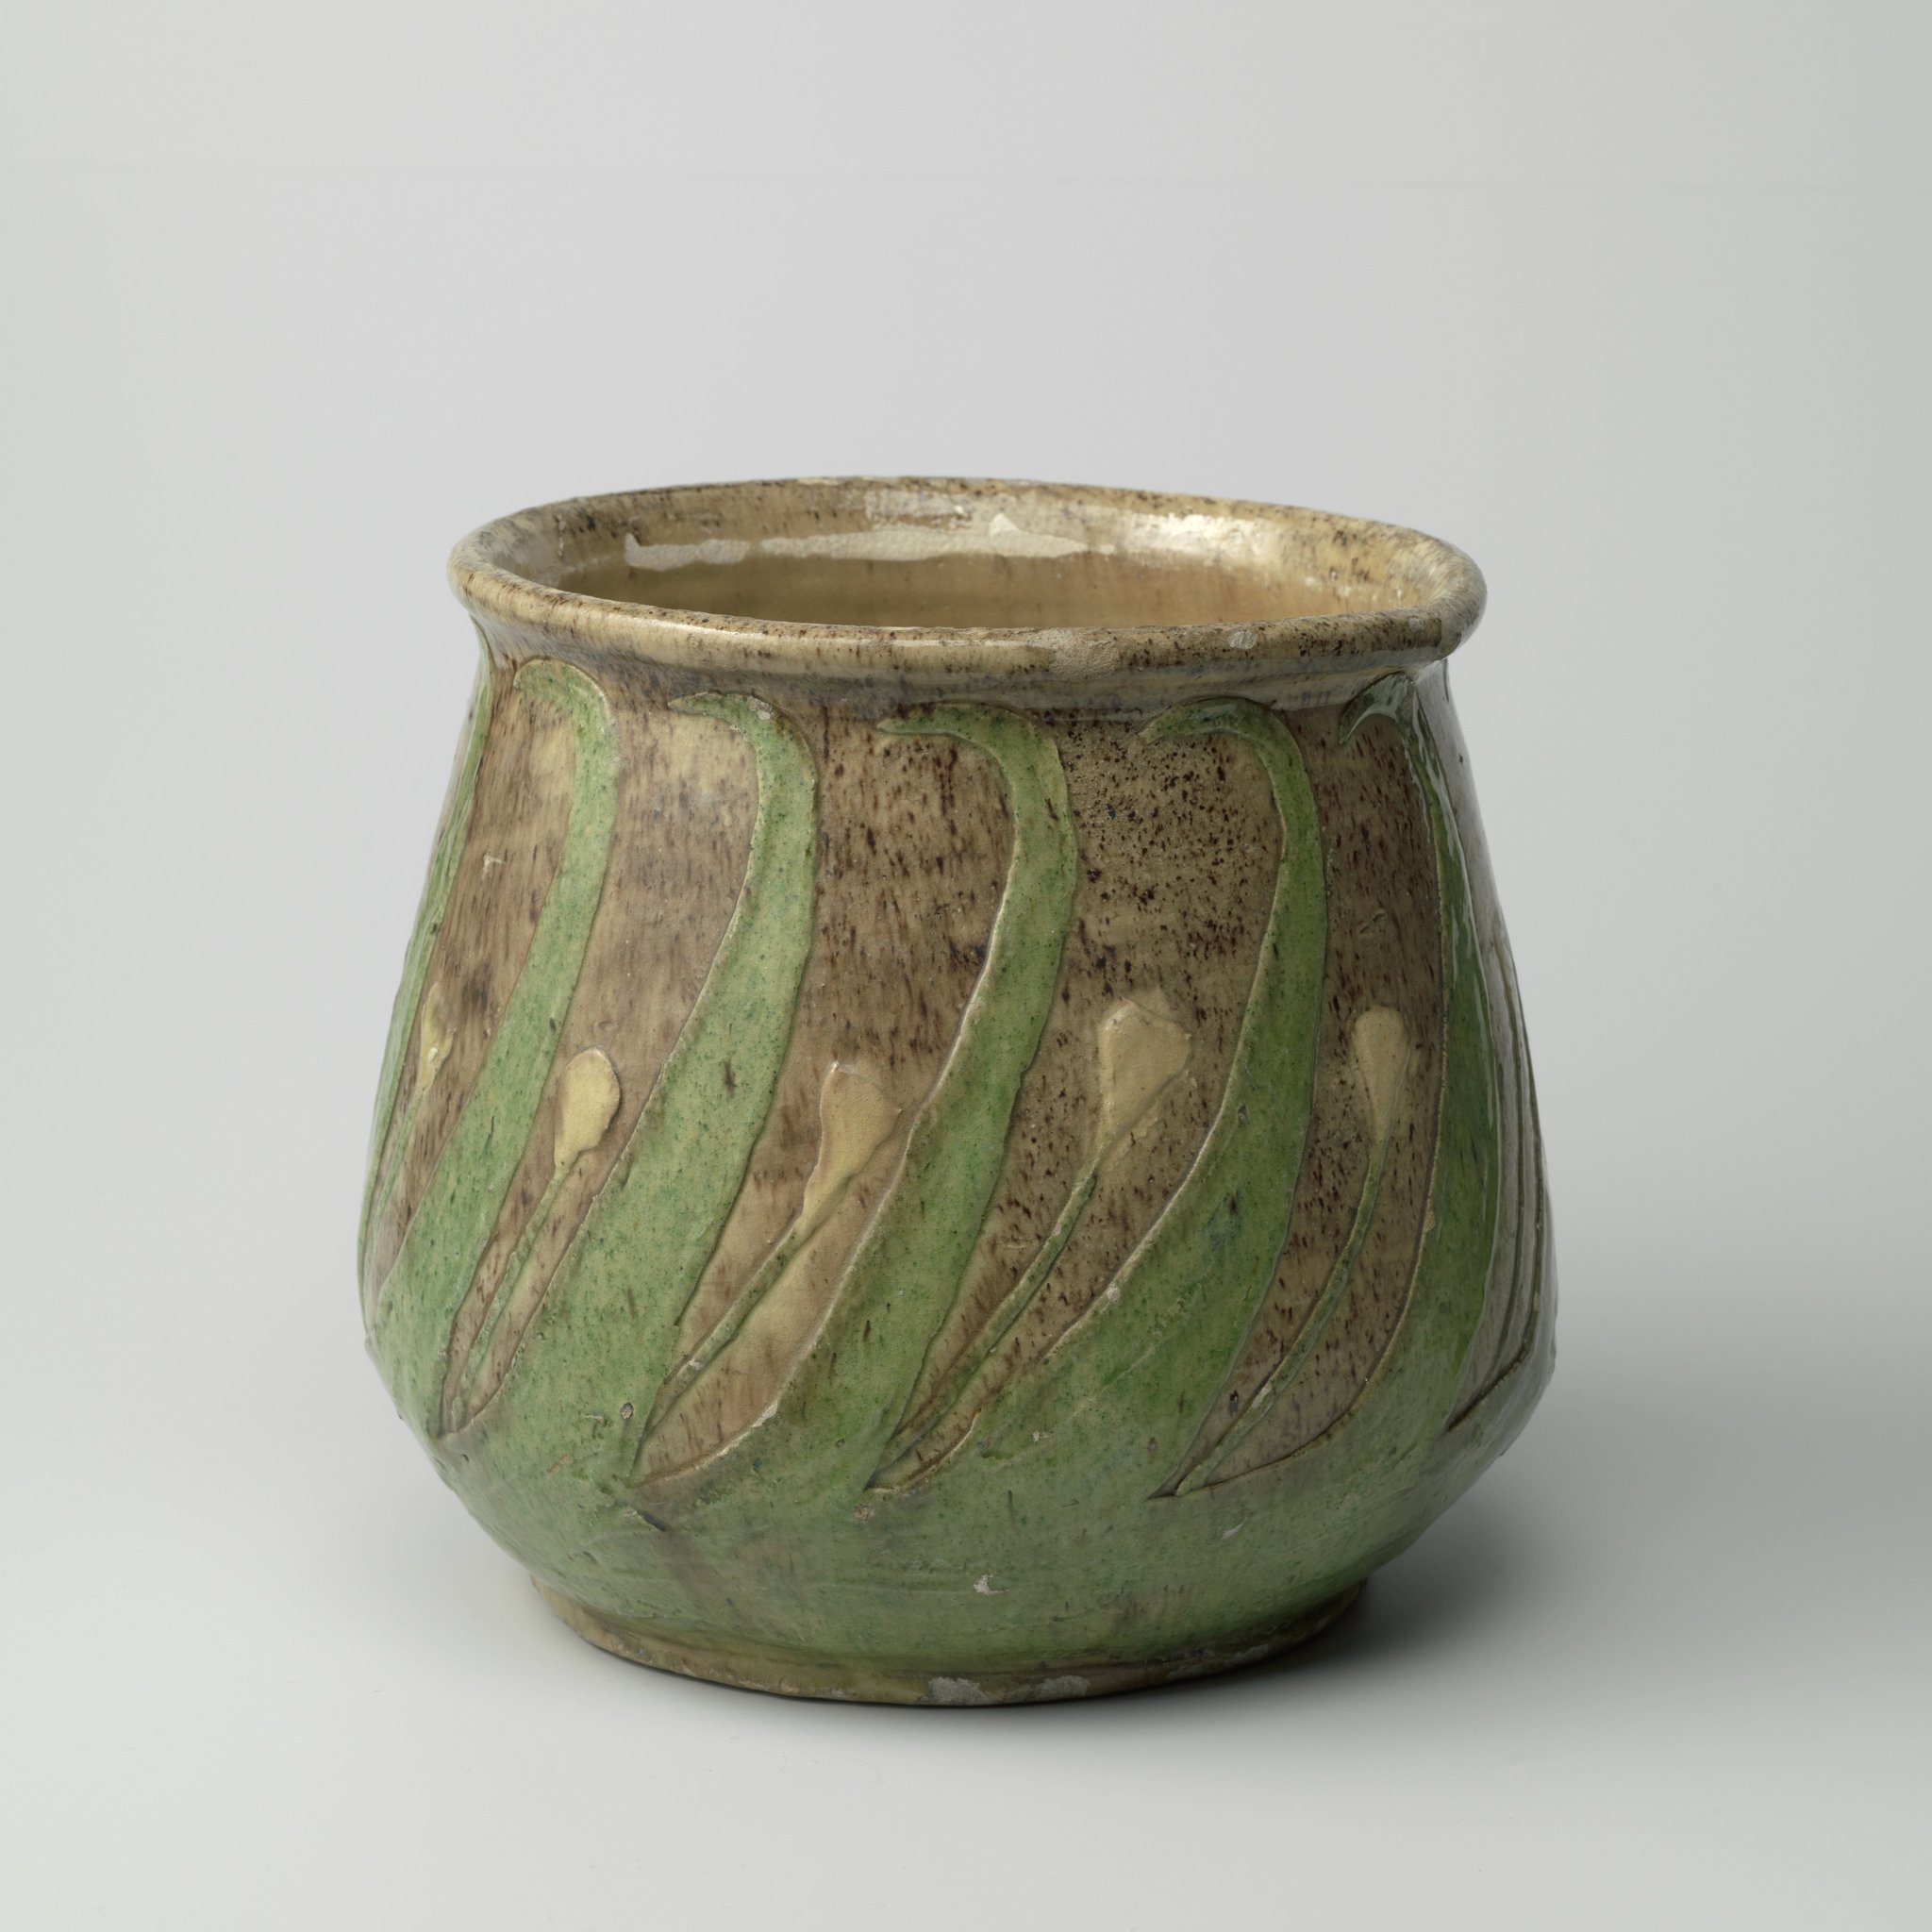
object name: pot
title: Pot met dessin van lancetbladeren in groen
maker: Anonymous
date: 1900-1925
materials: earthenware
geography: netherlands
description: Pot van aardewerk. De wand versierd in reliëf met slanke spits toelopende en bovenaan omkrullende groene bladeren, waartussen steeds een beige bloem aan een groene stengel, alles tegen een paars gemarmerde fond. Ongemerkt.